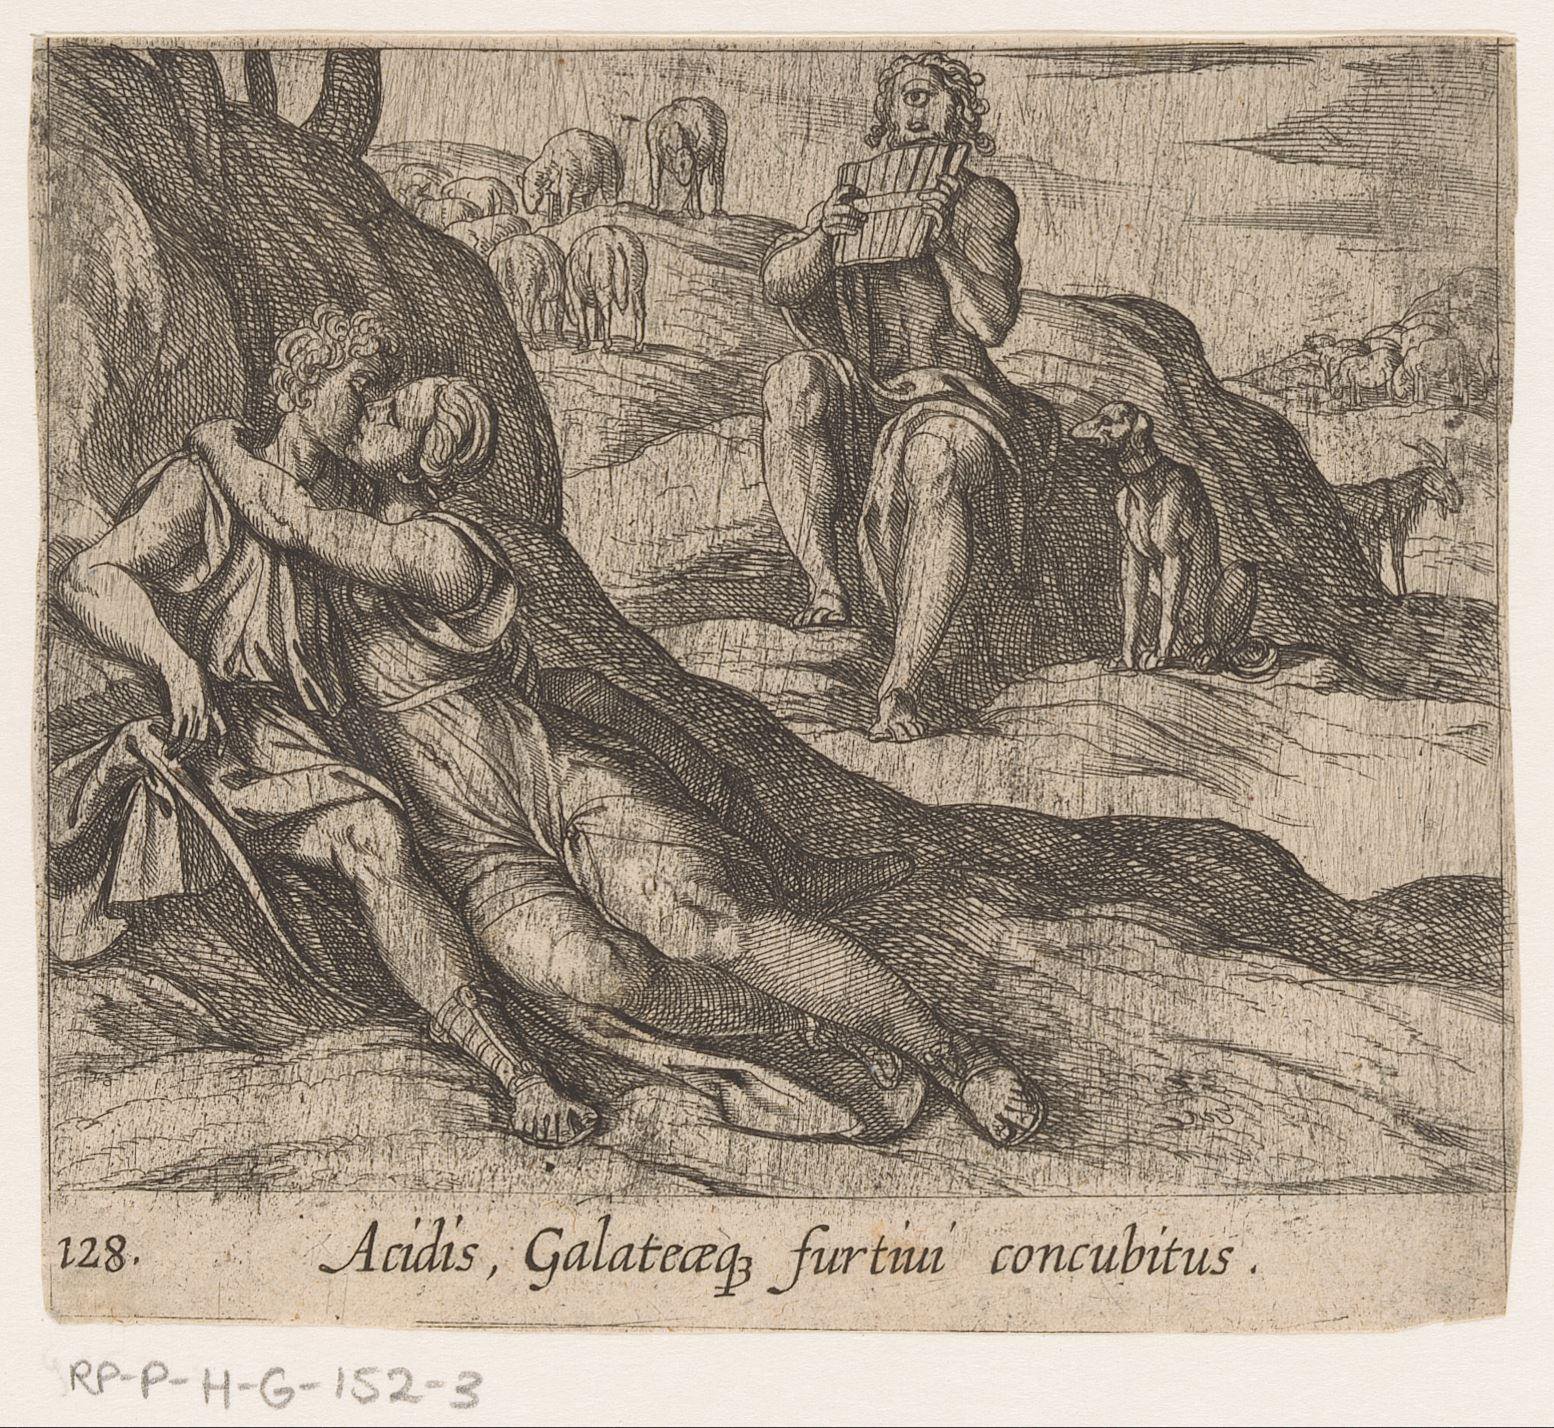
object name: print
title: Metamorfosen van Ovidius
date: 1606-1638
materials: paper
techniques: etching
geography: italy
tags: acis wooing galatea, polyphemus, the cyclops, beholding acis and galatea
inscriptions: collector's mark: ‘Hinloopen’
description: Onder een boom liefkozen Acis en Galatea elkaar. Polyphemus, de eenogige reus die ook verliefd was op Galatea, speelt op zijn panfluit. Titel in het Latijn in ondermarge.